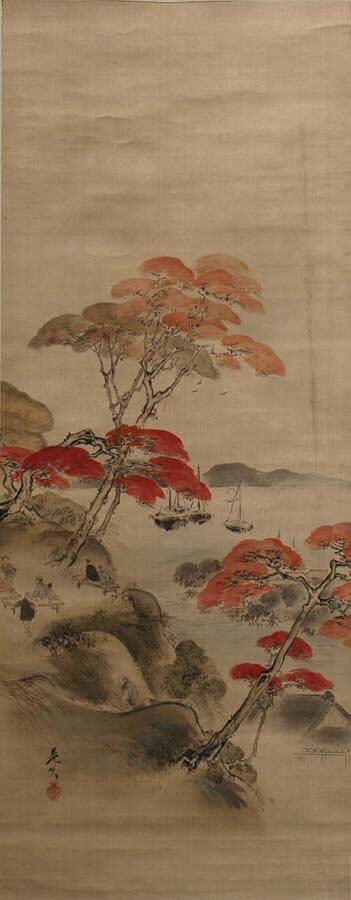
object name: hanging scroll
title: Maple Viewing at Kai'anji Temple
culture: japanese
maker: shibata zeshin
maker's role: artist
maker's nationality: japanese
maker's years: 1807-1891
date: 1851-1900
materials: ink, silk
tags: landscapes,trees,boats